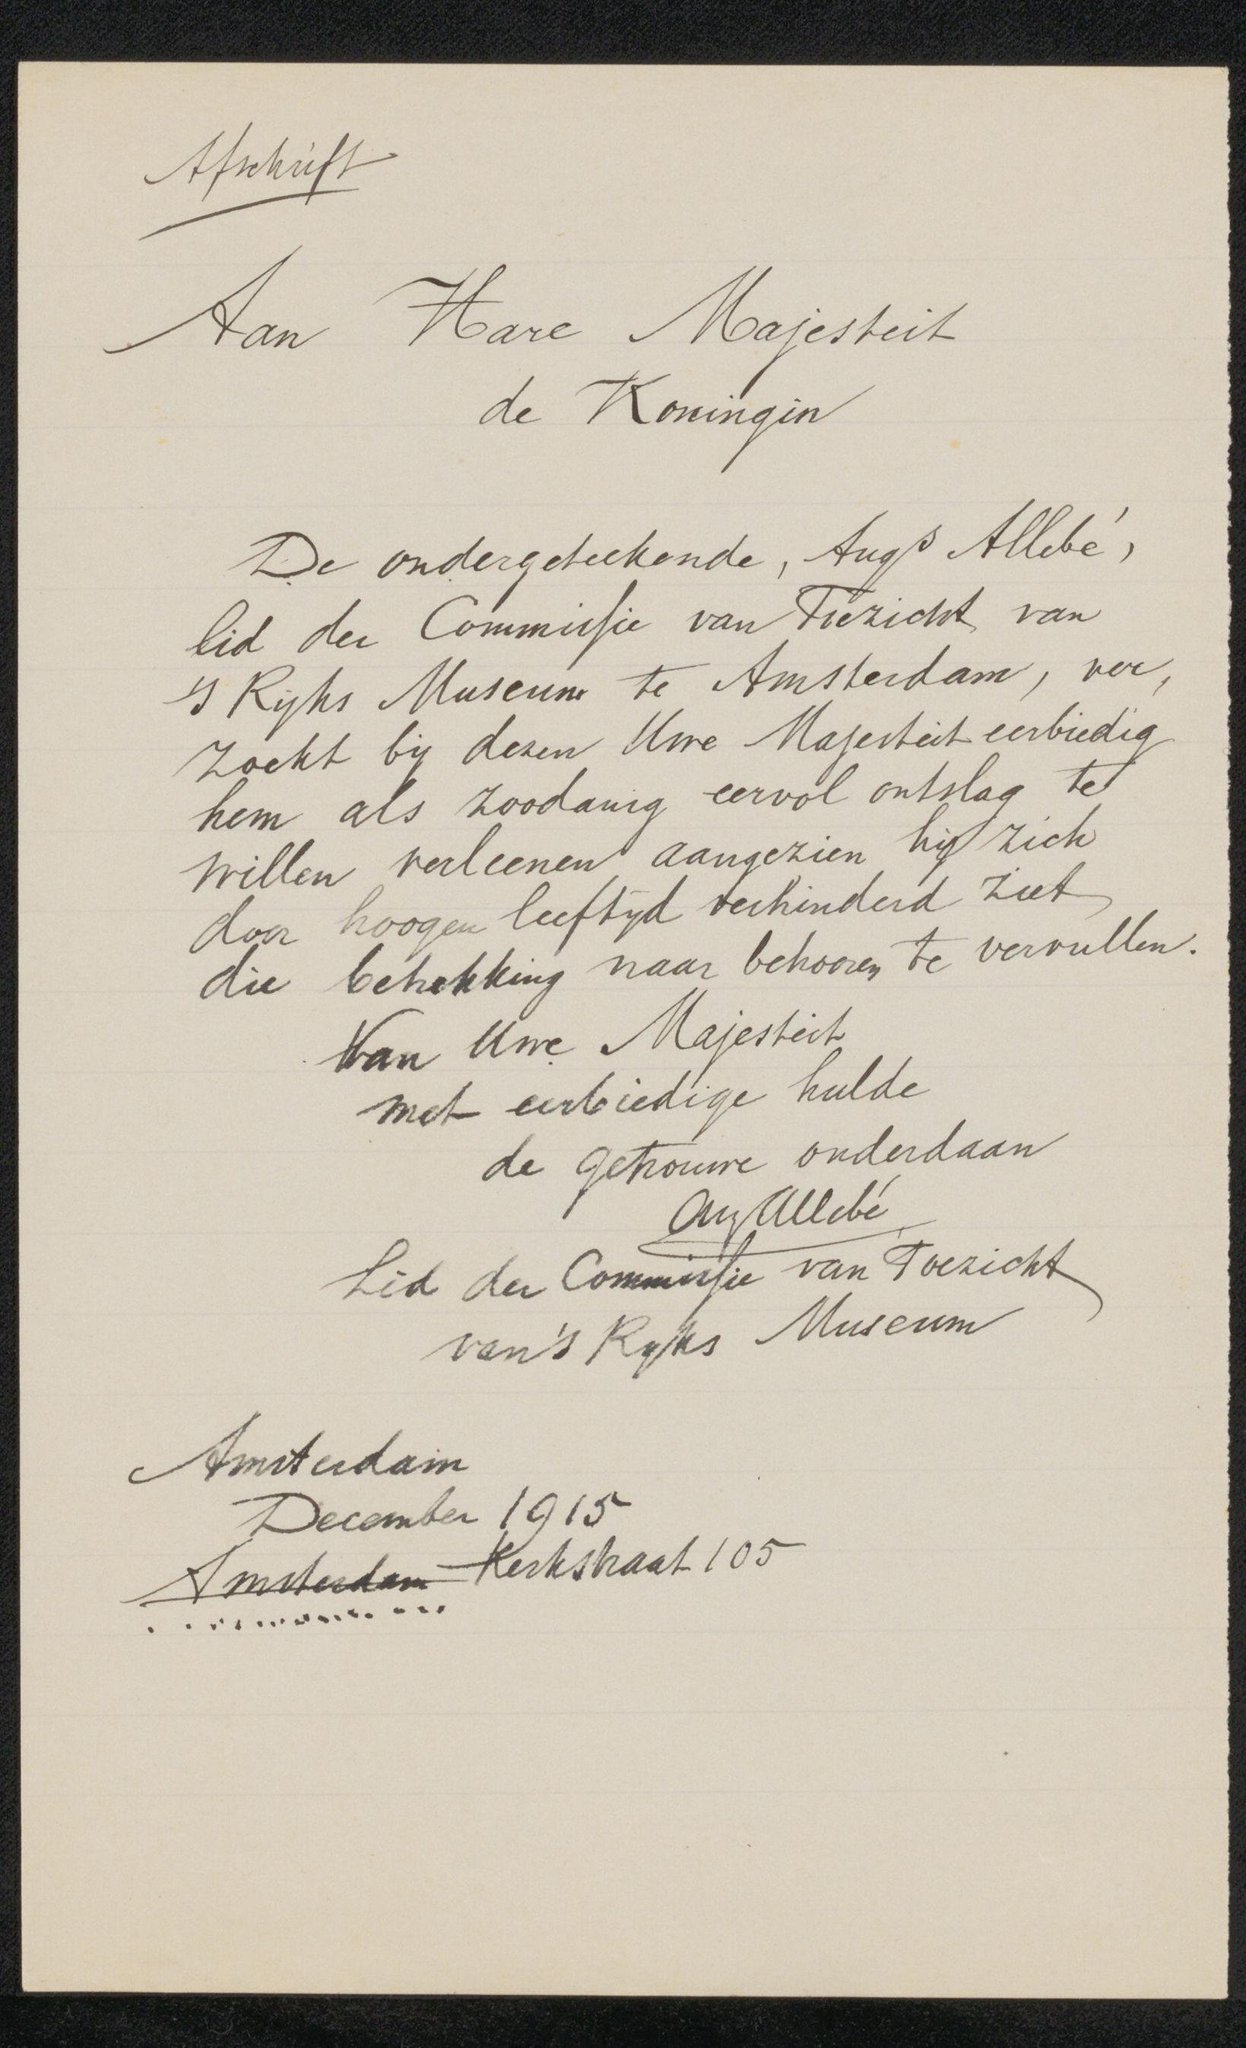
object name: letter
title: Brief aan Wilhelmina (koningin der Nederlanden)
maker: august allebé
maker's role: draughtsman, print maker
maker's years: 1838-1927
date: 1912-1915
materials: ink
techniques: pen, writing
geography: amsterdam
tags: print maker, wilhelmina of the netherlands, rijksmuseum amsterdam